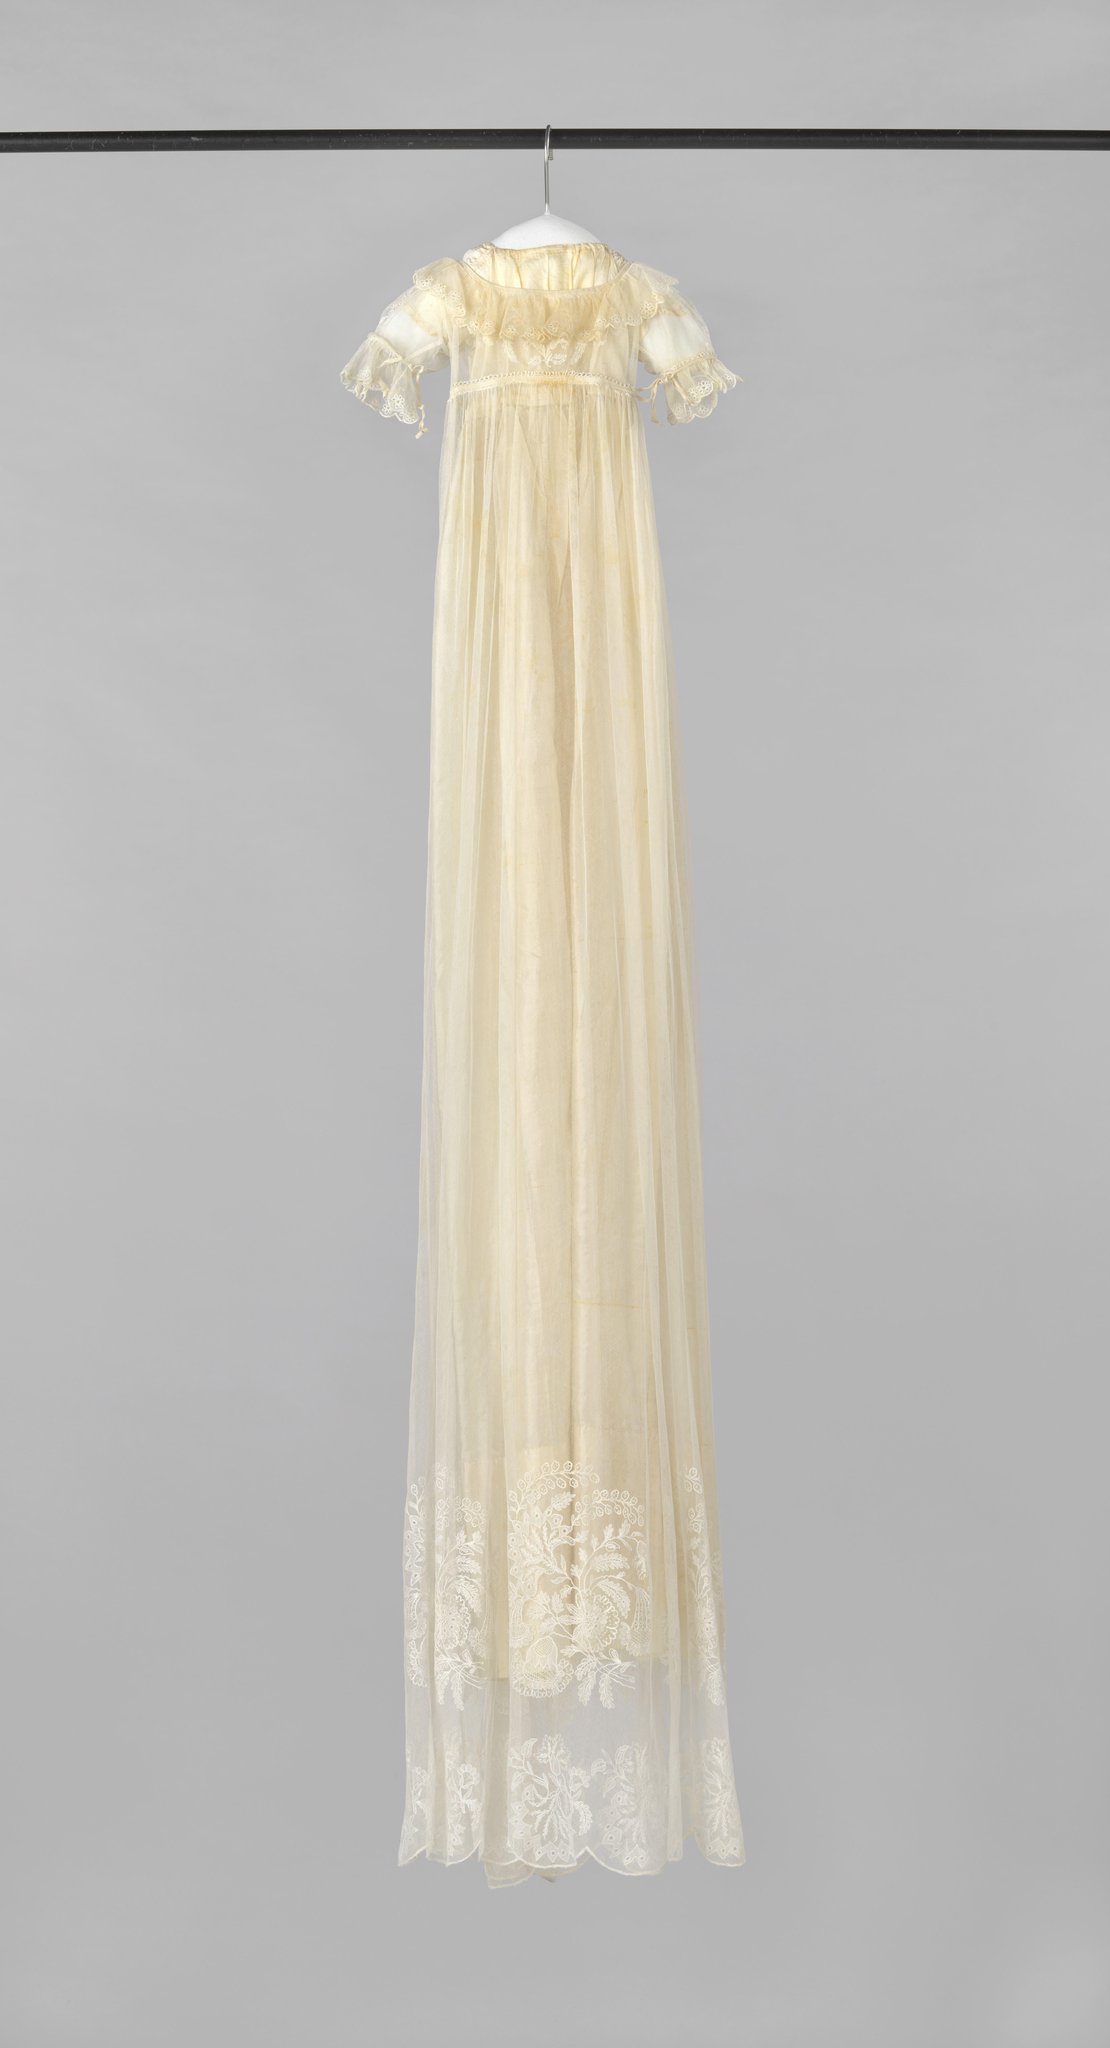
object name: baby wear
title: Een onderjurk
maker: Anonymous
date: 1820-1830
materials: silk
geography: netherlands